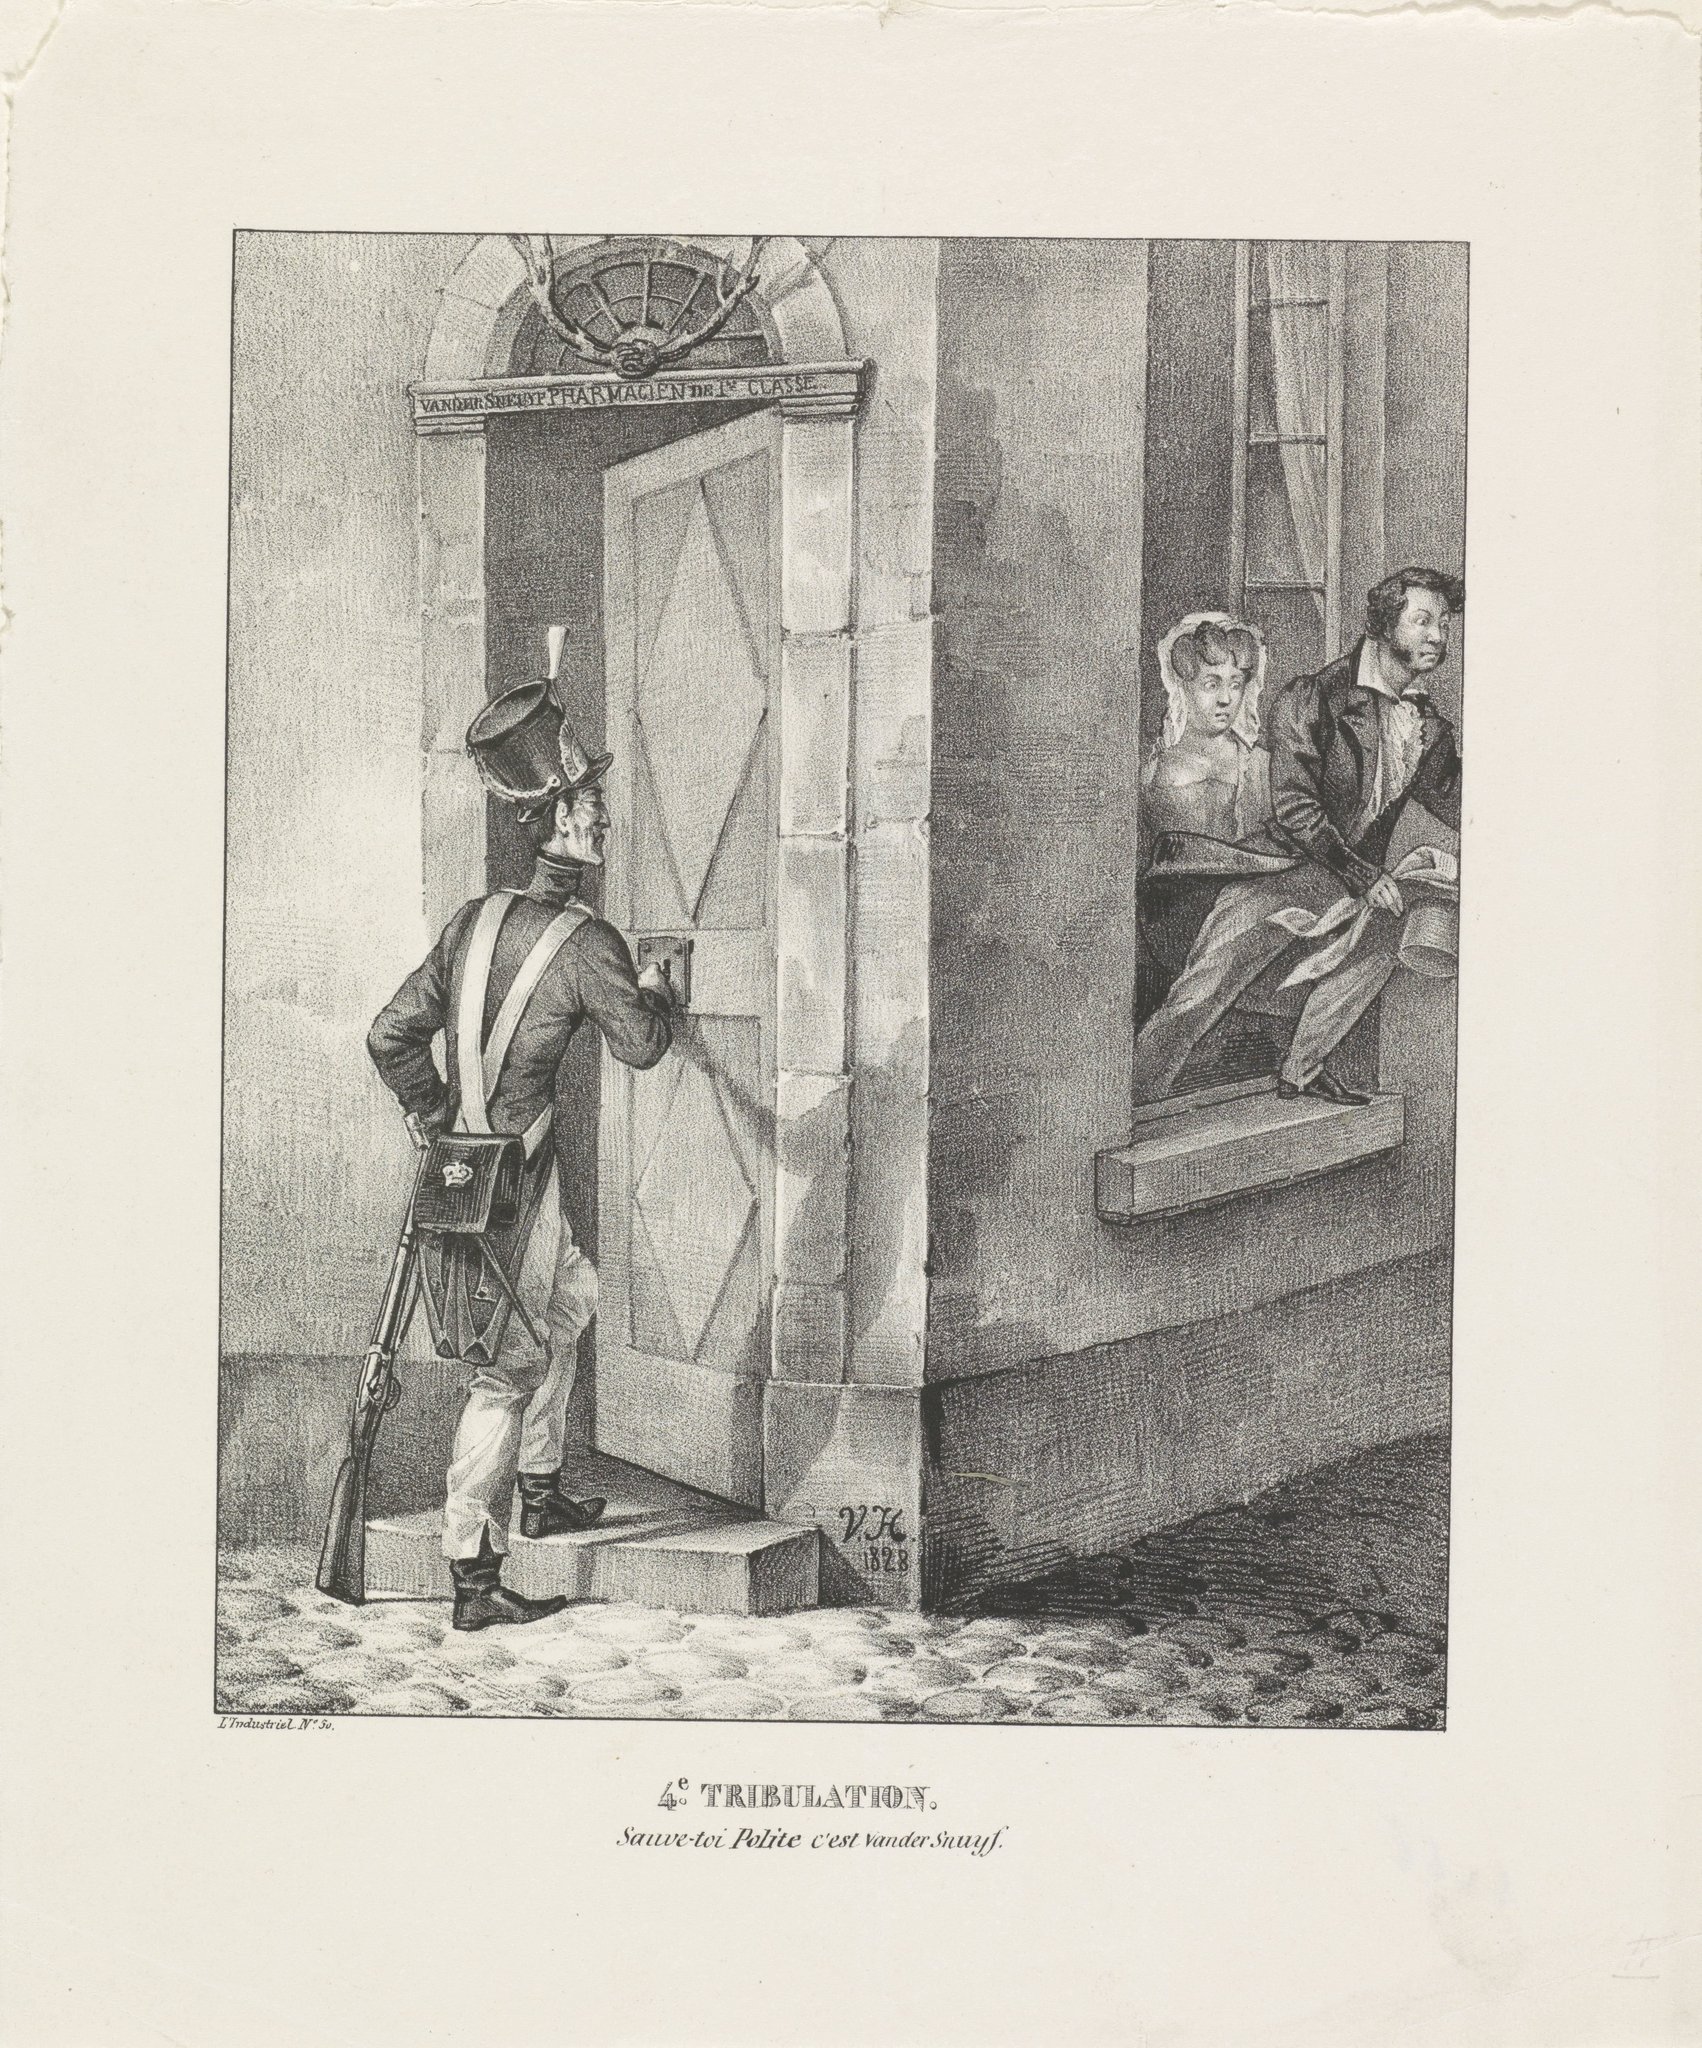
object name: print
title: 4e Tribulation. Sauve-toi Polite c'est van der Snuyf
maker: jean-louis van hemelryck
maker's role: print maker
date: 1828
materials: paper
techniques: lithograph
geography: southern netherlands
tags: the soldier; the soldier's life, interrupted meeting, lovers caught by surprise, belgium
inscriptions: collector's mark: Lugt 2228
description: De minnaar van de vrouw vlucht uit het raam als Van der Snuyf onverwacht thuiskomt. Onderdeel van een serie van ca. 24 spotprenten uit 1828 op de wanverhoudingen binnen de Belgische schutterijen door de maatschappelijke ongelijkheid binnen het korps, na de reorganisatie ingevoerd op 11 april 1827.